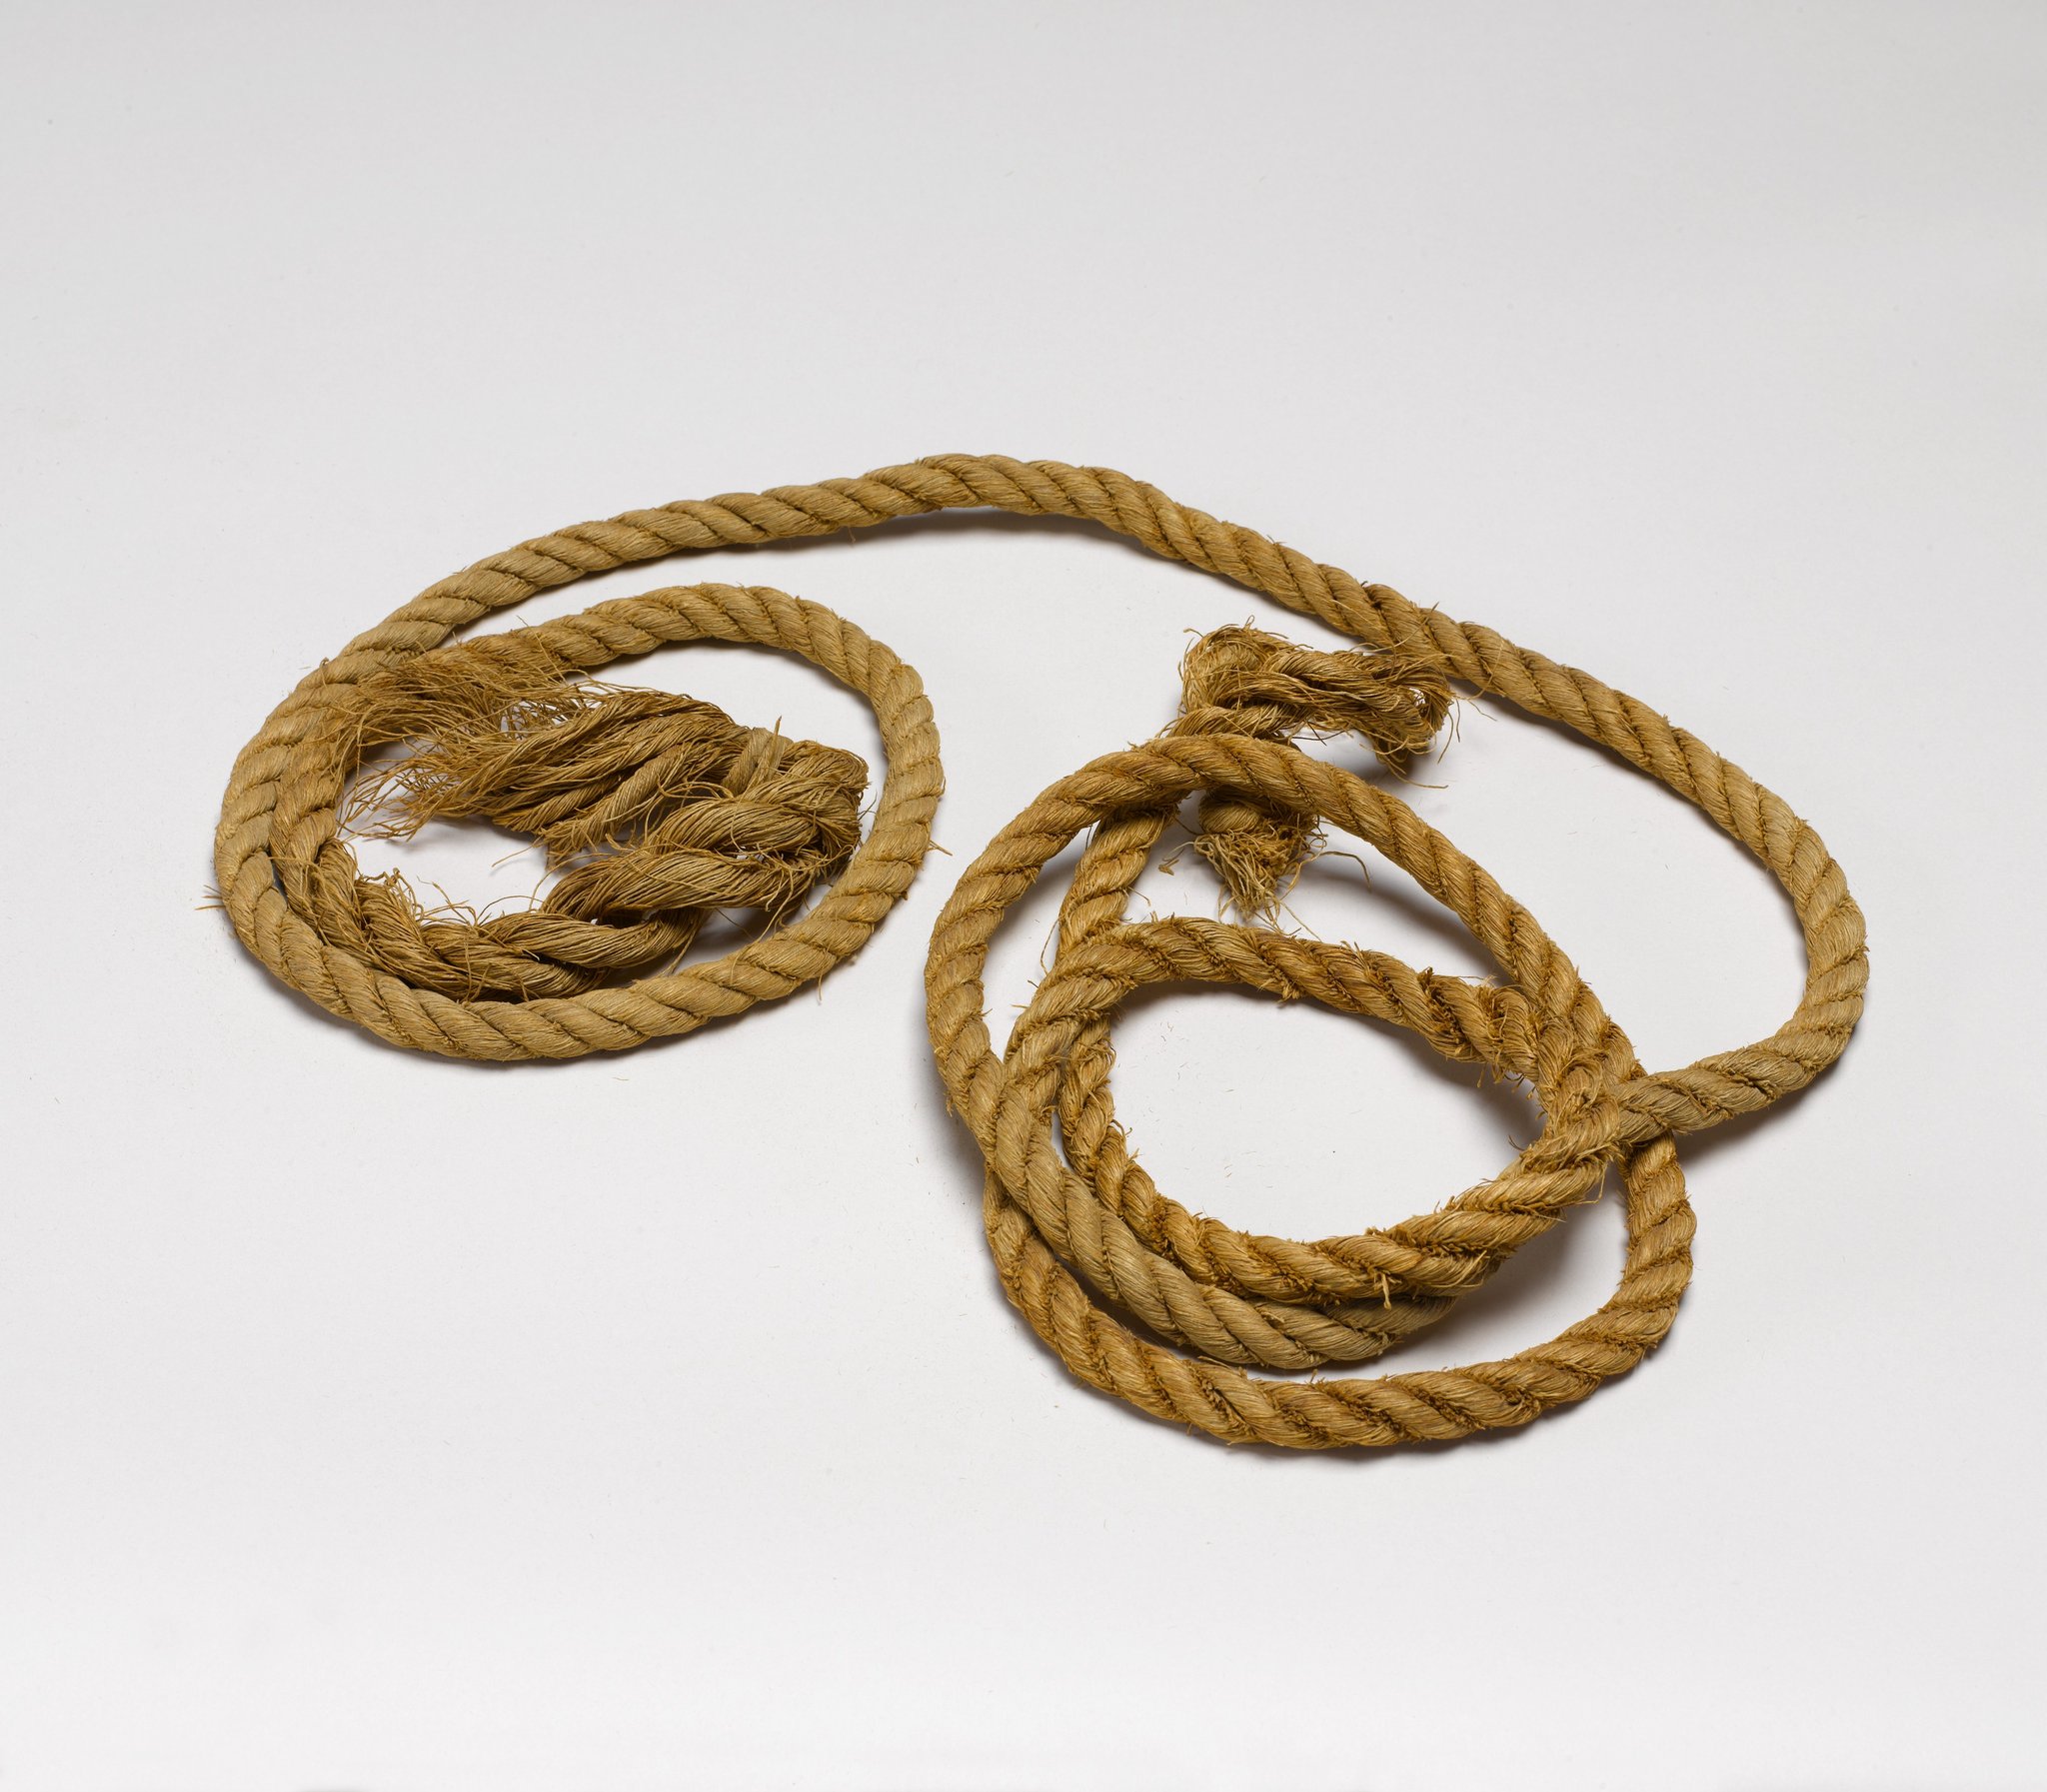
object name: rope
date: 2030-1640 BCE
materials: fiber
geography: egypt